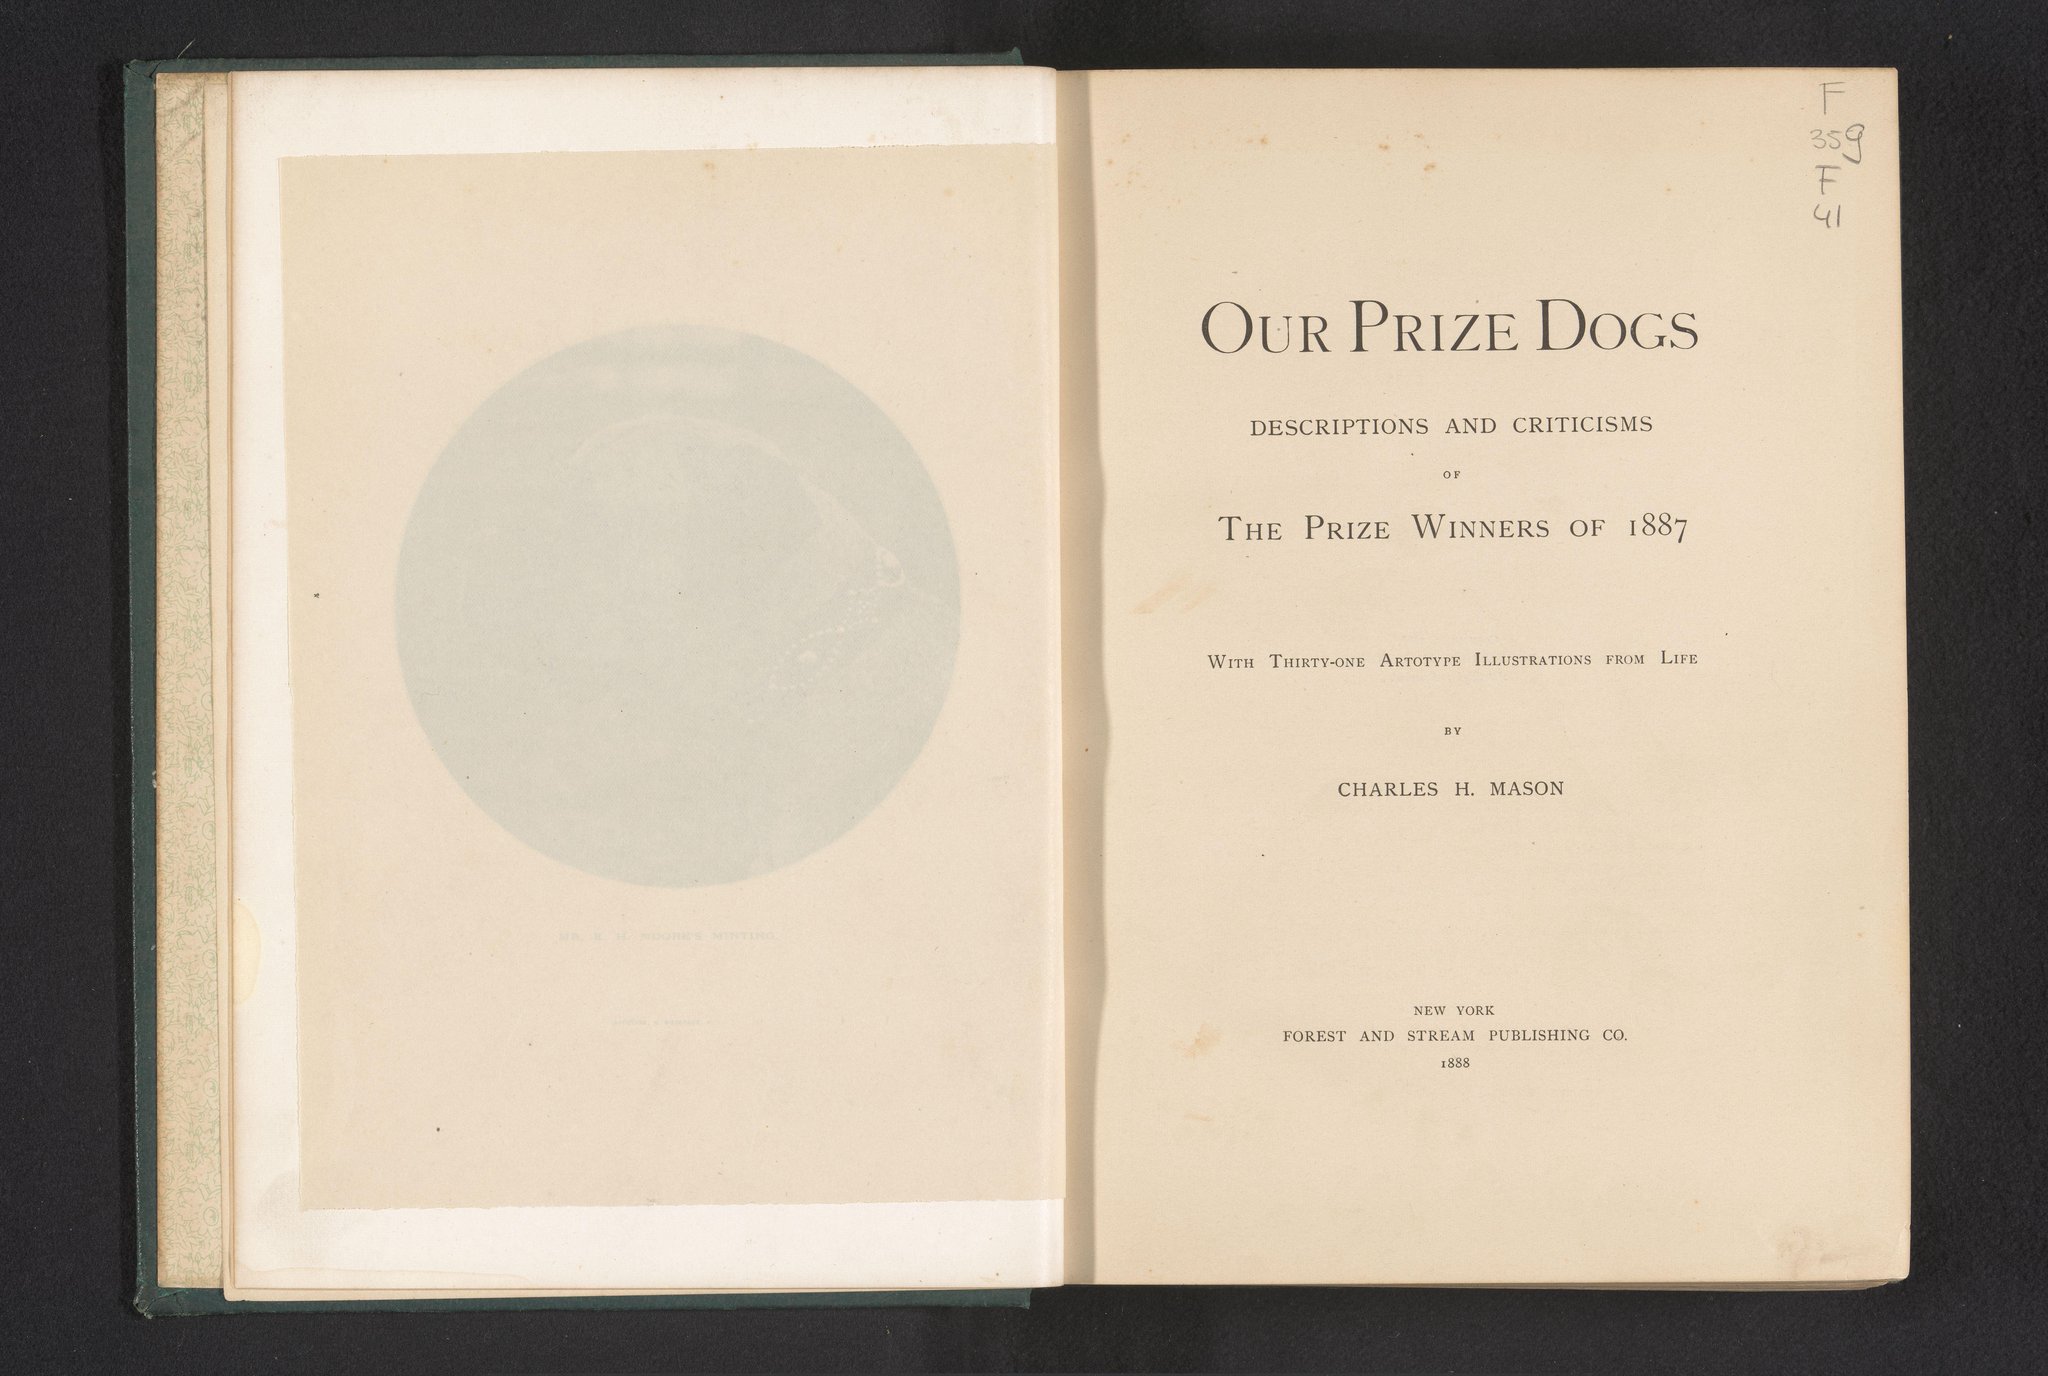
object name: book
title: Our prize dogs : descriptions and criticisms of the prize winners of 1887 / by Charles H. Mason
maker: charles h. mason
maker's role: schrijver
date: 1888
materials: cardboard, linen, paper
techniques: photograph, printing, printing block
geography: new york city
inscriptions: annotation: ‘APR/ 1999’, number: ‘450,-/ 9000 Bet’